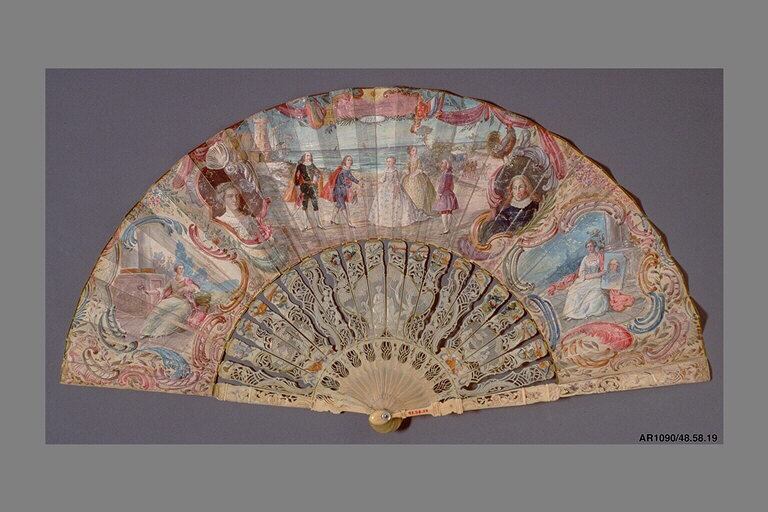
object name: fan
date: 1701-1800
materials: ivory, paper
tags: men,women